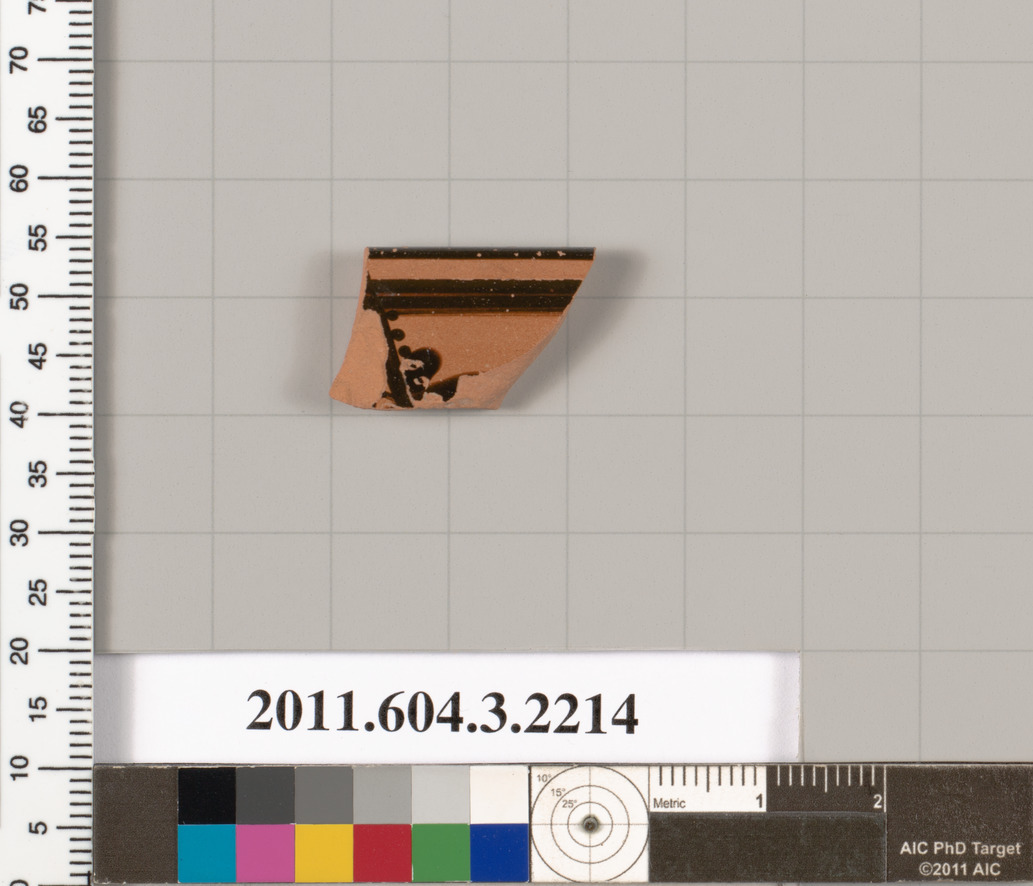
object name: kylix fragment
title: Terracotta rim fragment of a kylix (drinking cup)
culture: greek, attic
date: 600-401 BCE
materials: terracotta